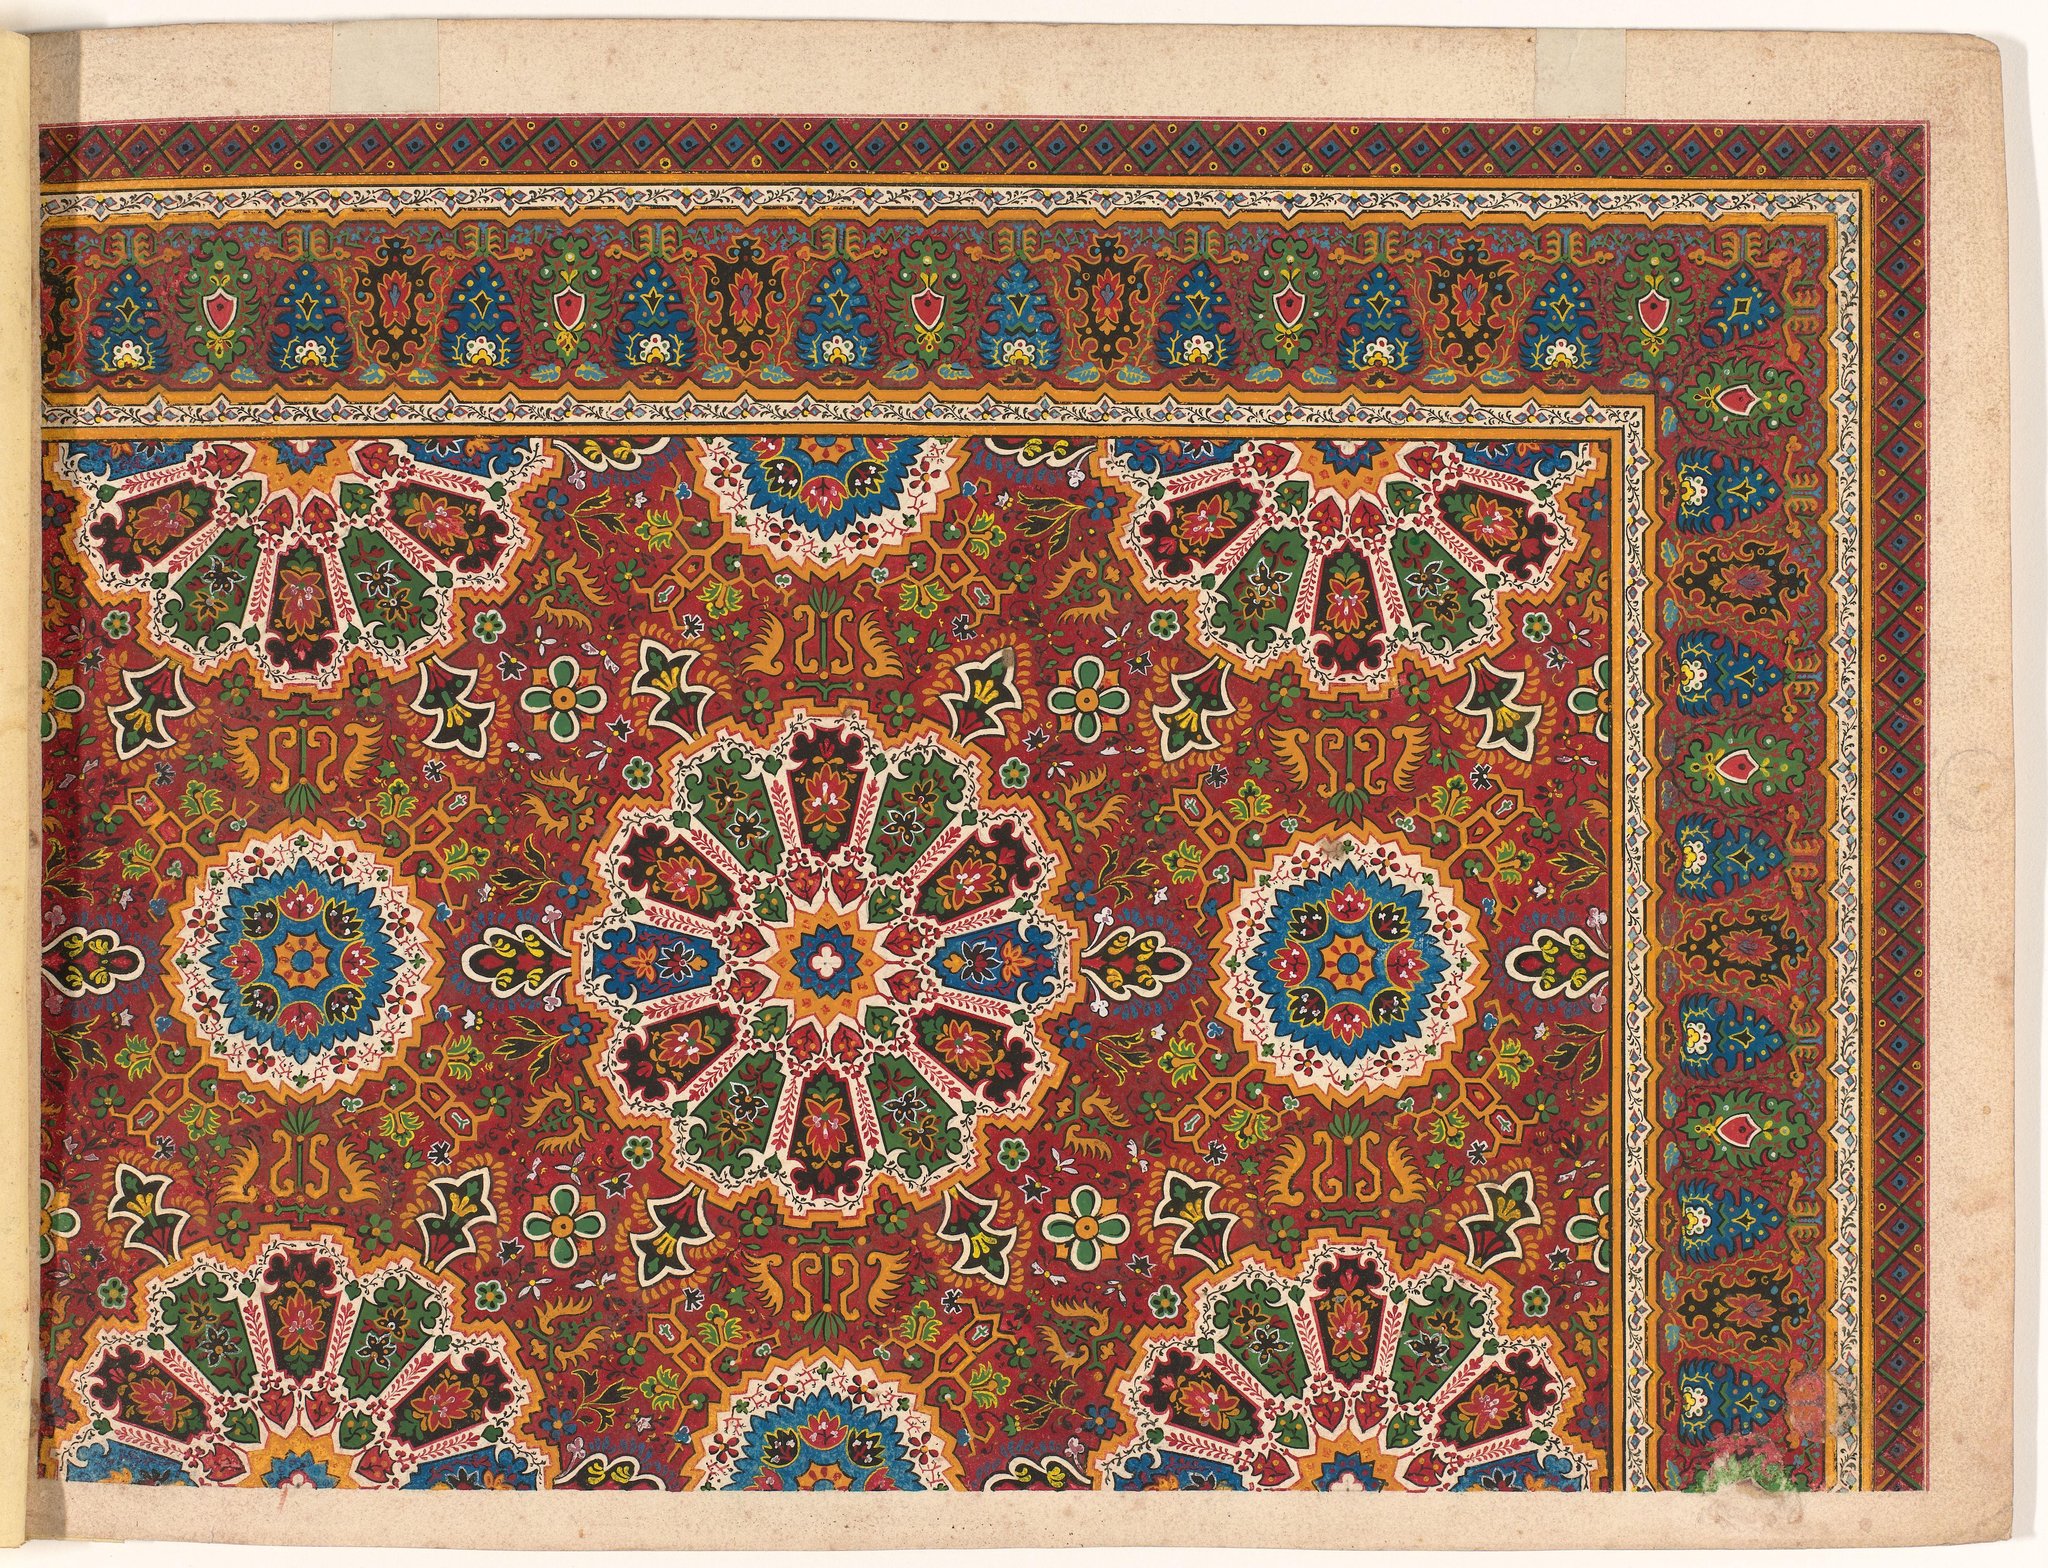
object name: design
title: Ontwerp voor een tapijt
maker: Anonymous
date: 1854-1864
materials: gouache, paper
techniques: brush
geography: deventer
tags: ornaments ~ art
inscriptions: retailer's mark: ‘JHS.’, inscription: ‘B s.’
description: De presentatietekeningen BK-1971-77-1 t/m 86 zijn kopieën van de originele ontwerptekeningen. Ze werden gemaakt voor vertegenwoordigers van bijvoorbeeld magazijnen, die ze aan hun klanten konden tonen. De meeste tekeningen tonen een kwart van het dessin inclusief rand, middenpartij (de zogenaamde grond of fond) en centraal medaillon. Door het gebruik van spiegels kan de illusie van het gehele tapijt worden opgeroepen. Een deel van de tekeningen heeft een alfabetische opeenvolgende letter als kenmerk, de andere groep een cijfer.Waarschijnlijk is de reeks dessins met een letter eerder samengesteld dan de genummerde tekeningen.